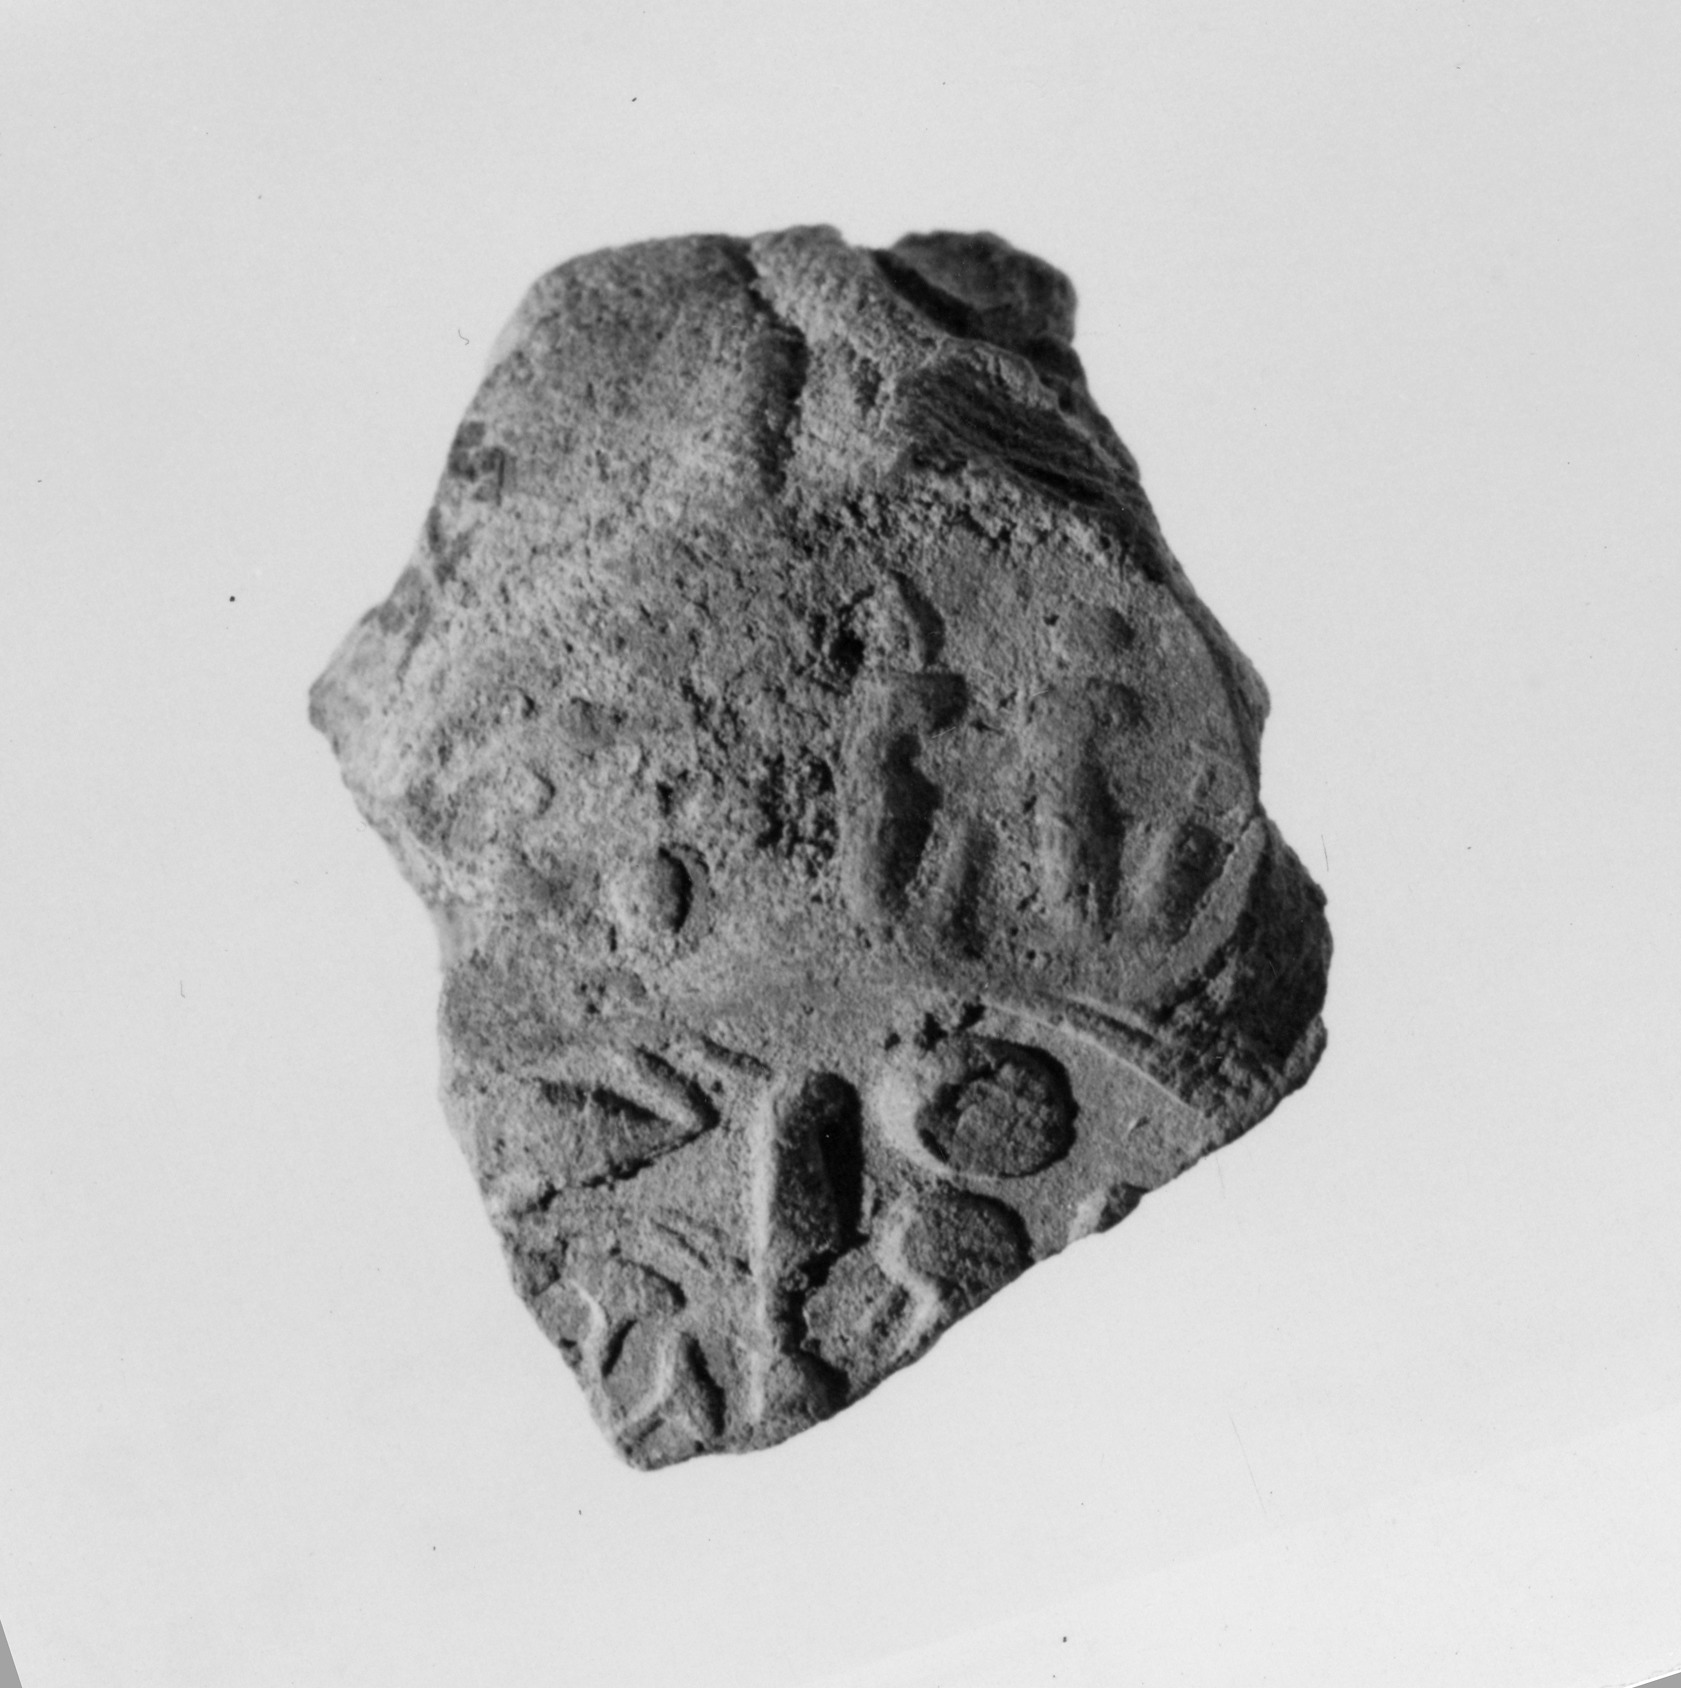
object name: sealing, nebmaatre, amenhotep iii,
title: Document Sealing With Multiple Seal Impressions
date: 1390-1352 BCE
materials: mud